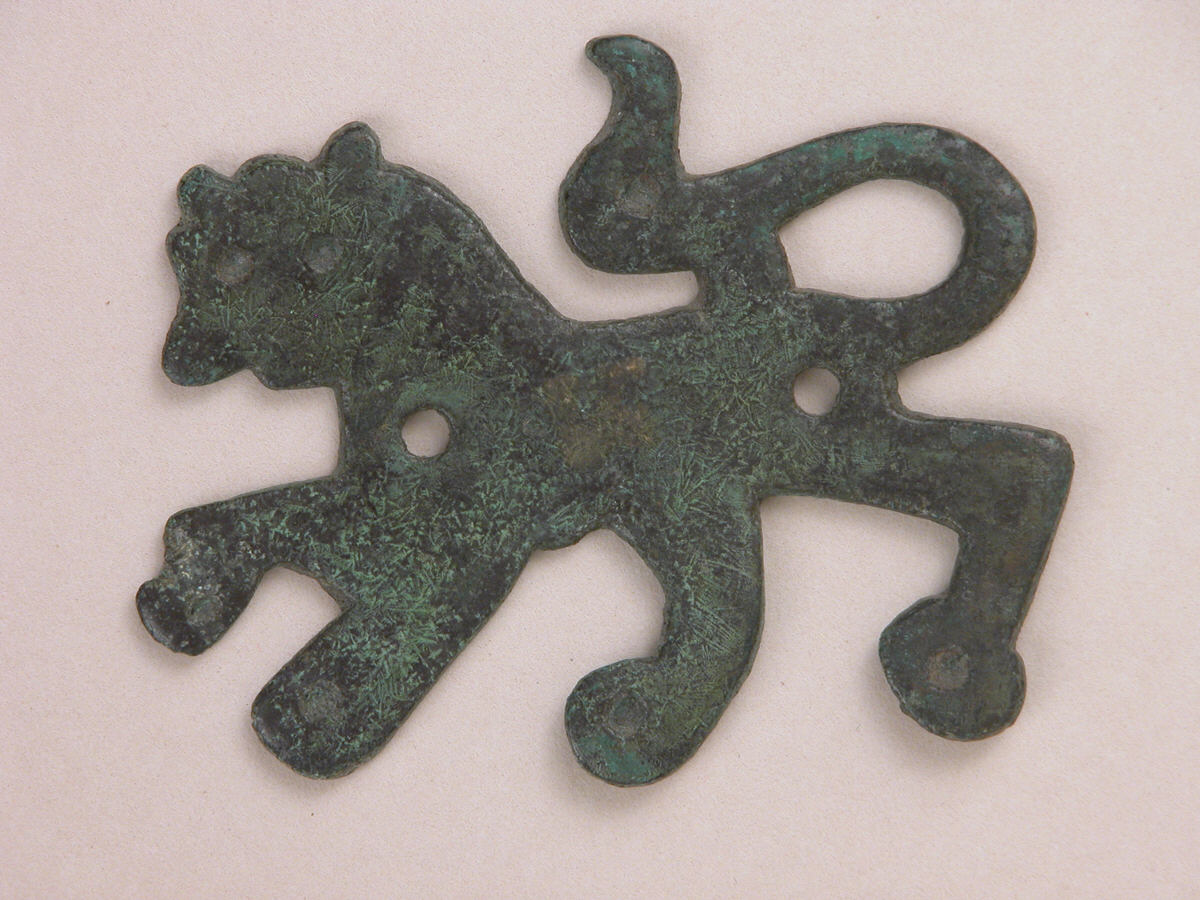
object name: plaque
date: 1251-1300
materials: bronze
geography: egypt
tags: animals